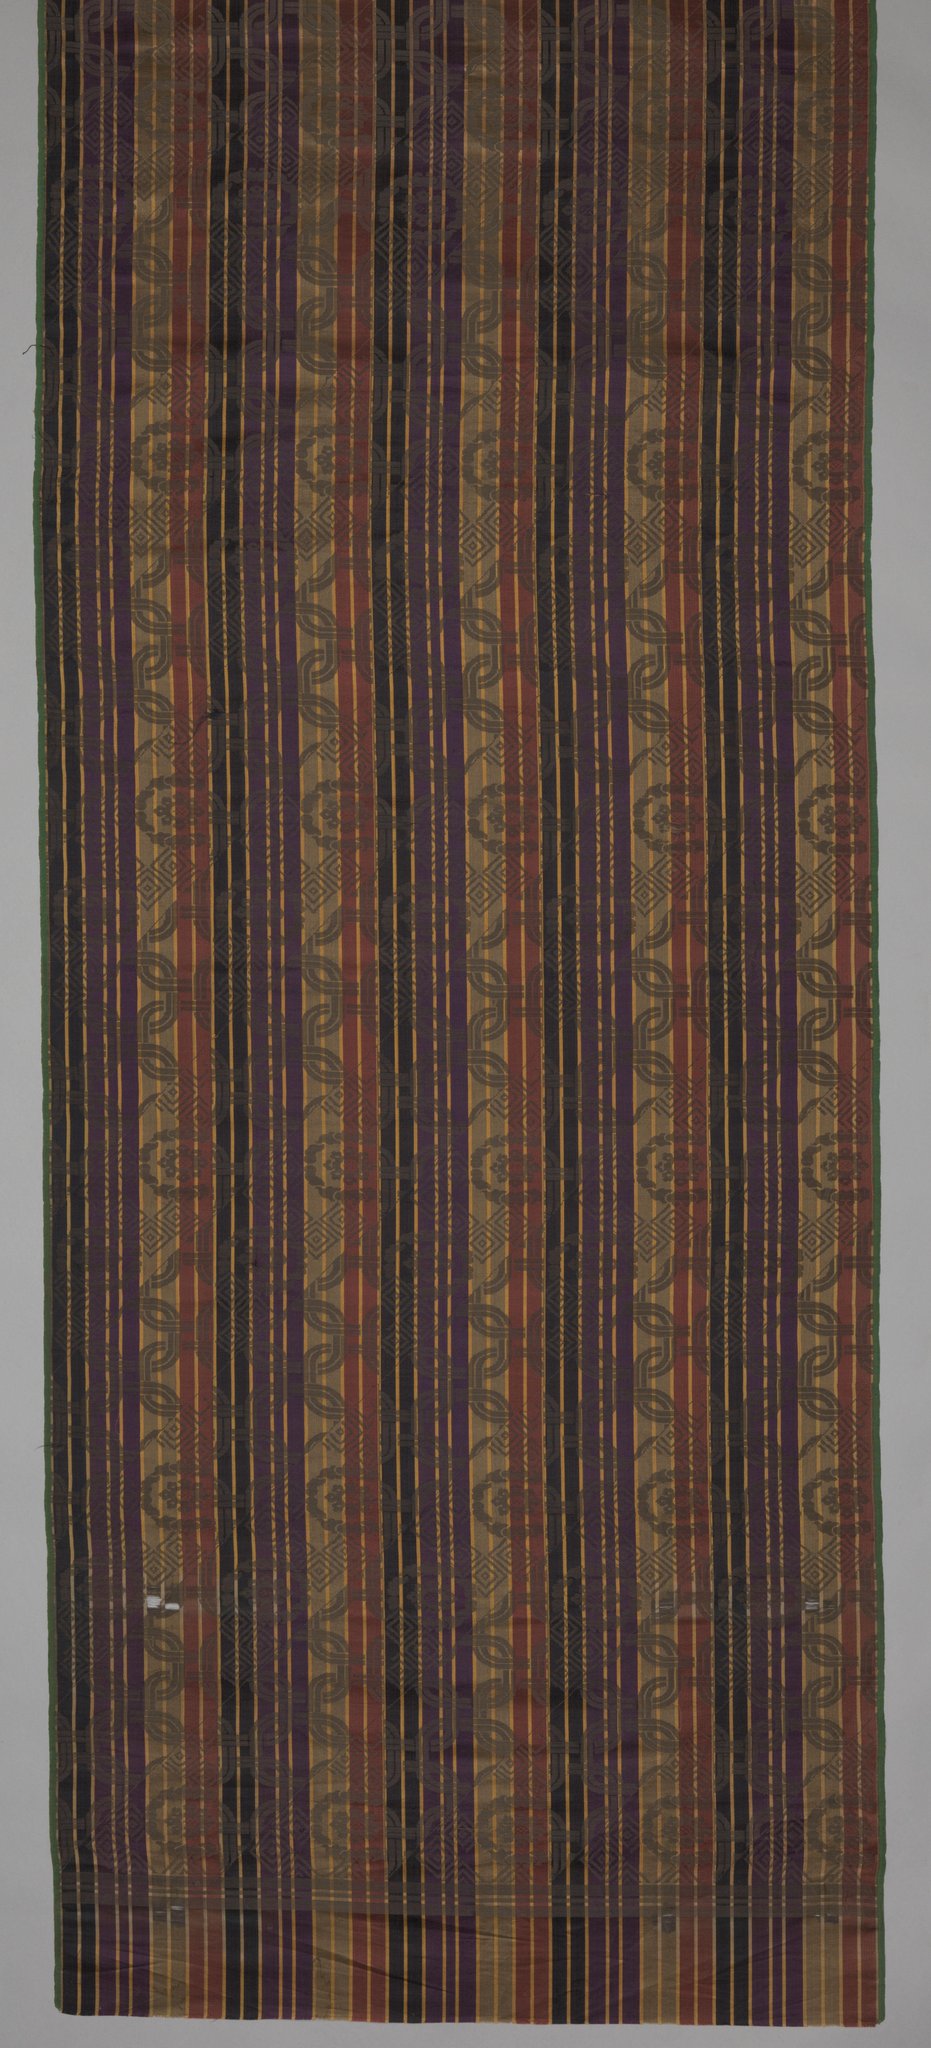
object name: textile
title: Baan zijdedamast met een dessin van strepen, onderbroken door smallere strepen "waaroverheen" een geschakeld ornament van bandwerk, bloemen en wyberornament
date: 1900-1920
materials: silk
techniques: damask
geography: japan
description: Baan zijdedamast met een dessin van strepen in donkerrood, lichtbruin, paars, zwart, onderbroken door smallere goudgele strepen "waaroverheen" een geschakeld ornament van bandwerk, bloemen en wyberornament. Oosterse textiel.